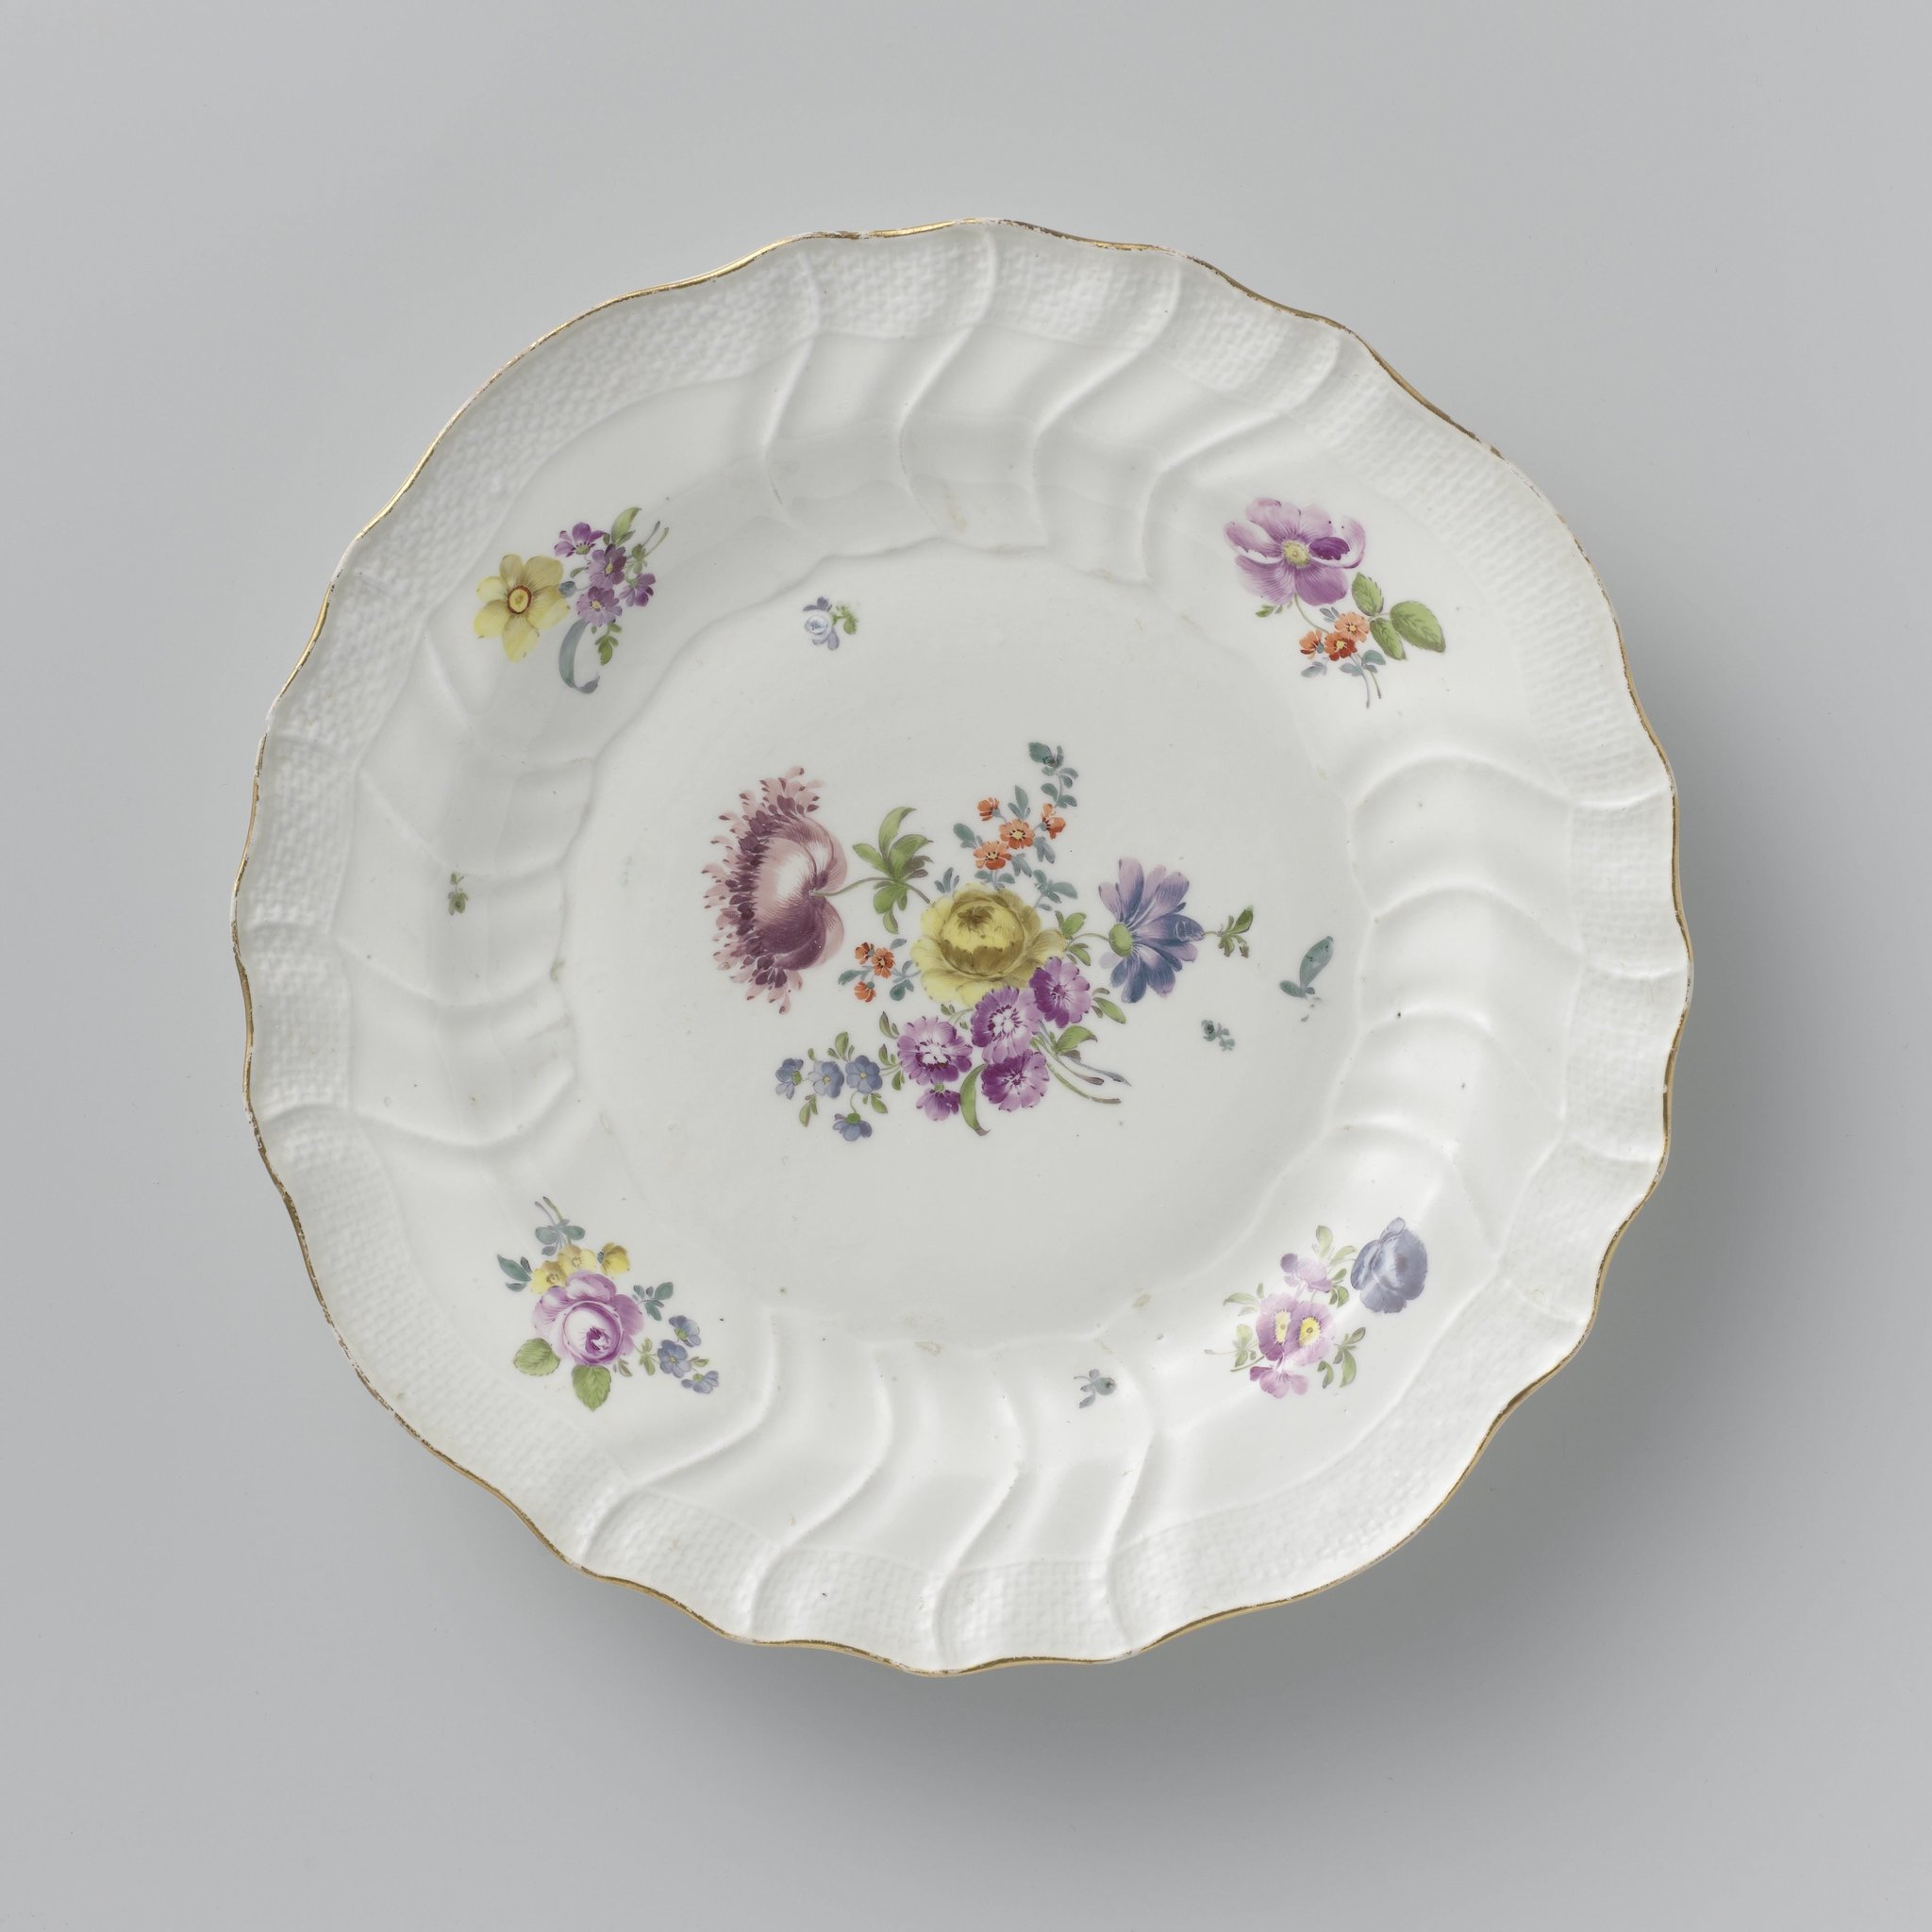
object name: plate dish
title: Bord, veelkleurig beschilderd met Deutsche Blumen, insekten en vruchten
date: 1750-1760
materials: porcelain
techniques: painted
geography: meissen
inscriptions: factory mark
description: Rond bord van beschilderd porselein. Het bord is beschilderd met Deutsche Blumen, insekten en vruchten. De rand is in reliëf versierd met het Neuozier-patroon. Het bord is gemerkt en hoort bij een servies (BK-17474-1 t/m BK-17474-253).